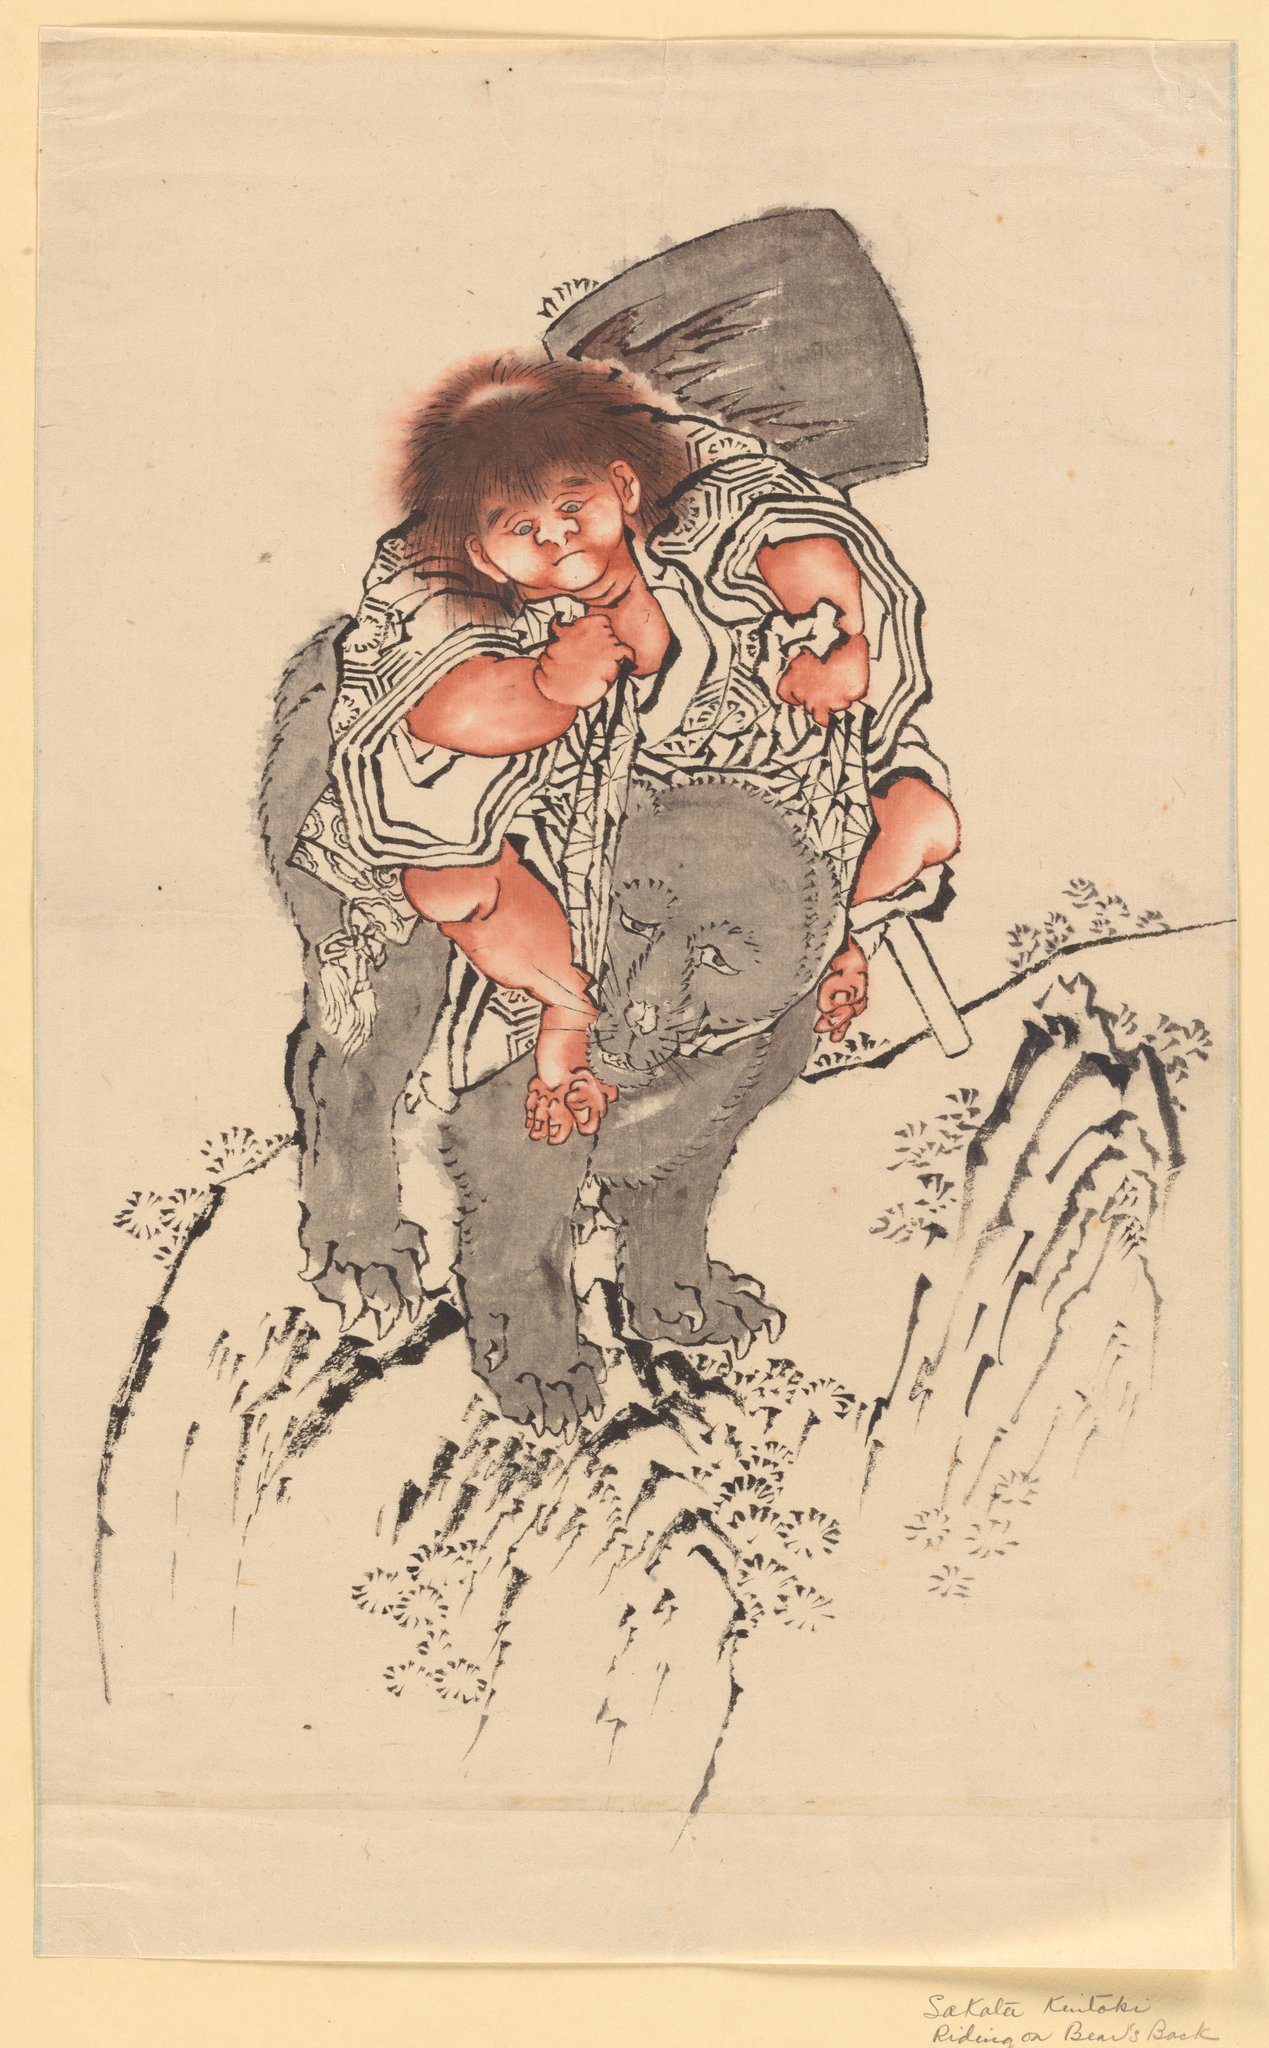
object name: drawing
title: Sakata Kintoki Riding on Bear's Back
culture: japanese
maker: katsushika hokusai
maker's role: artist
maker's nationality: japanese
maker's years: 1760-1849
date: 1701-1900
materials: ink, paper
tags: bears,men